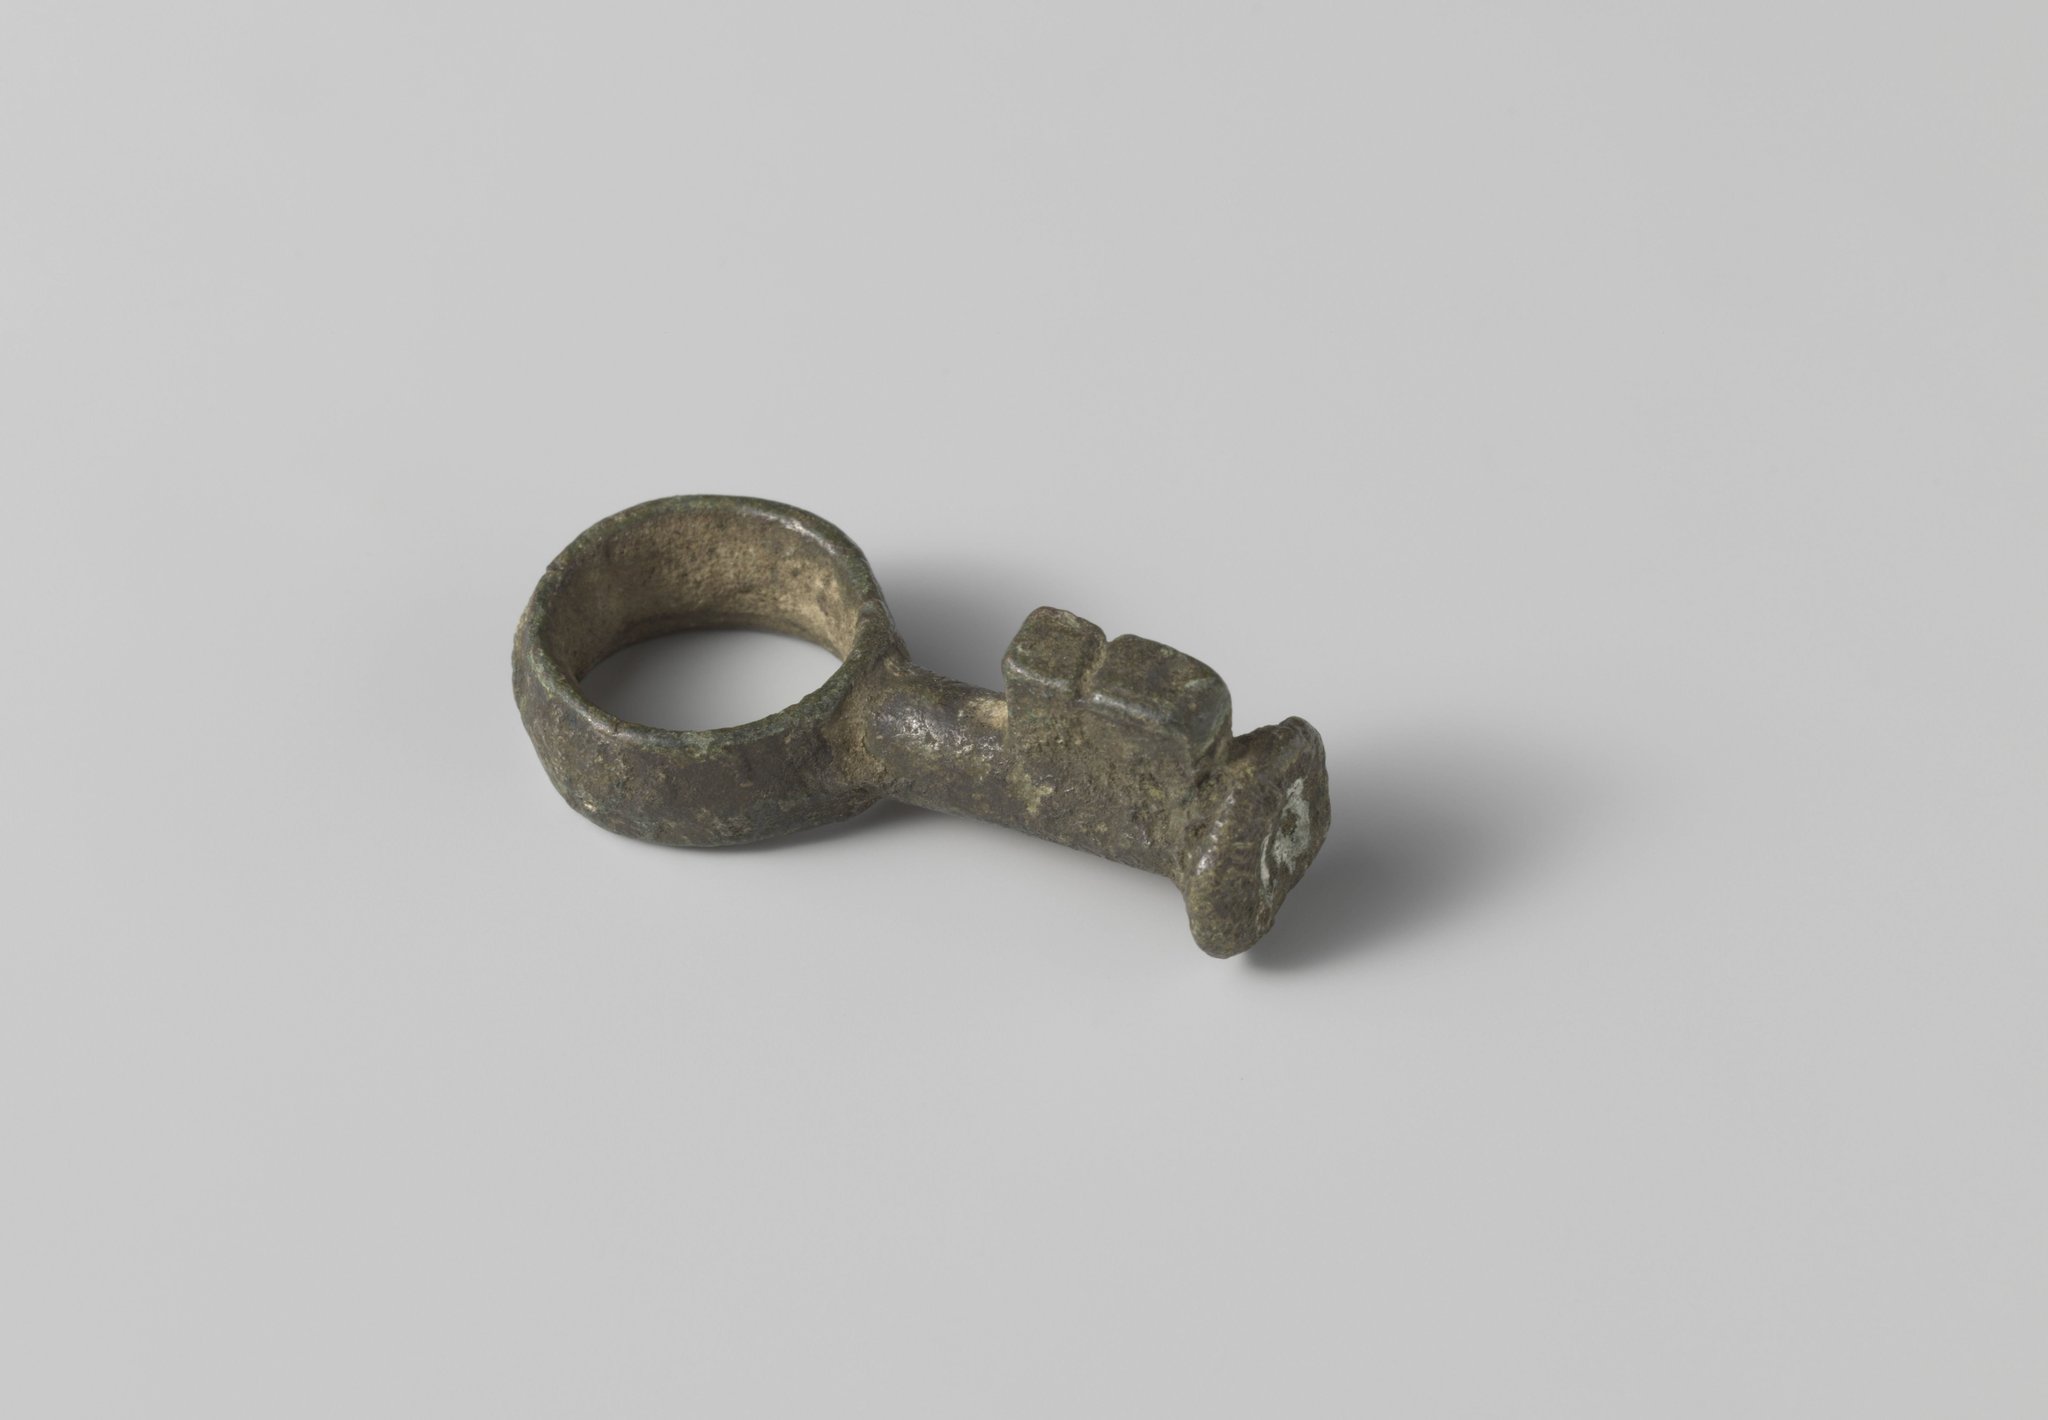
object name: key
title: Sleutel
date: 1200-1300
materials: bronze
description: Sleuteltje met groot ringvormig oog, korte schacht, onderaan schijfvormiig afgeplat. De baard staat loodrecht op het oog.